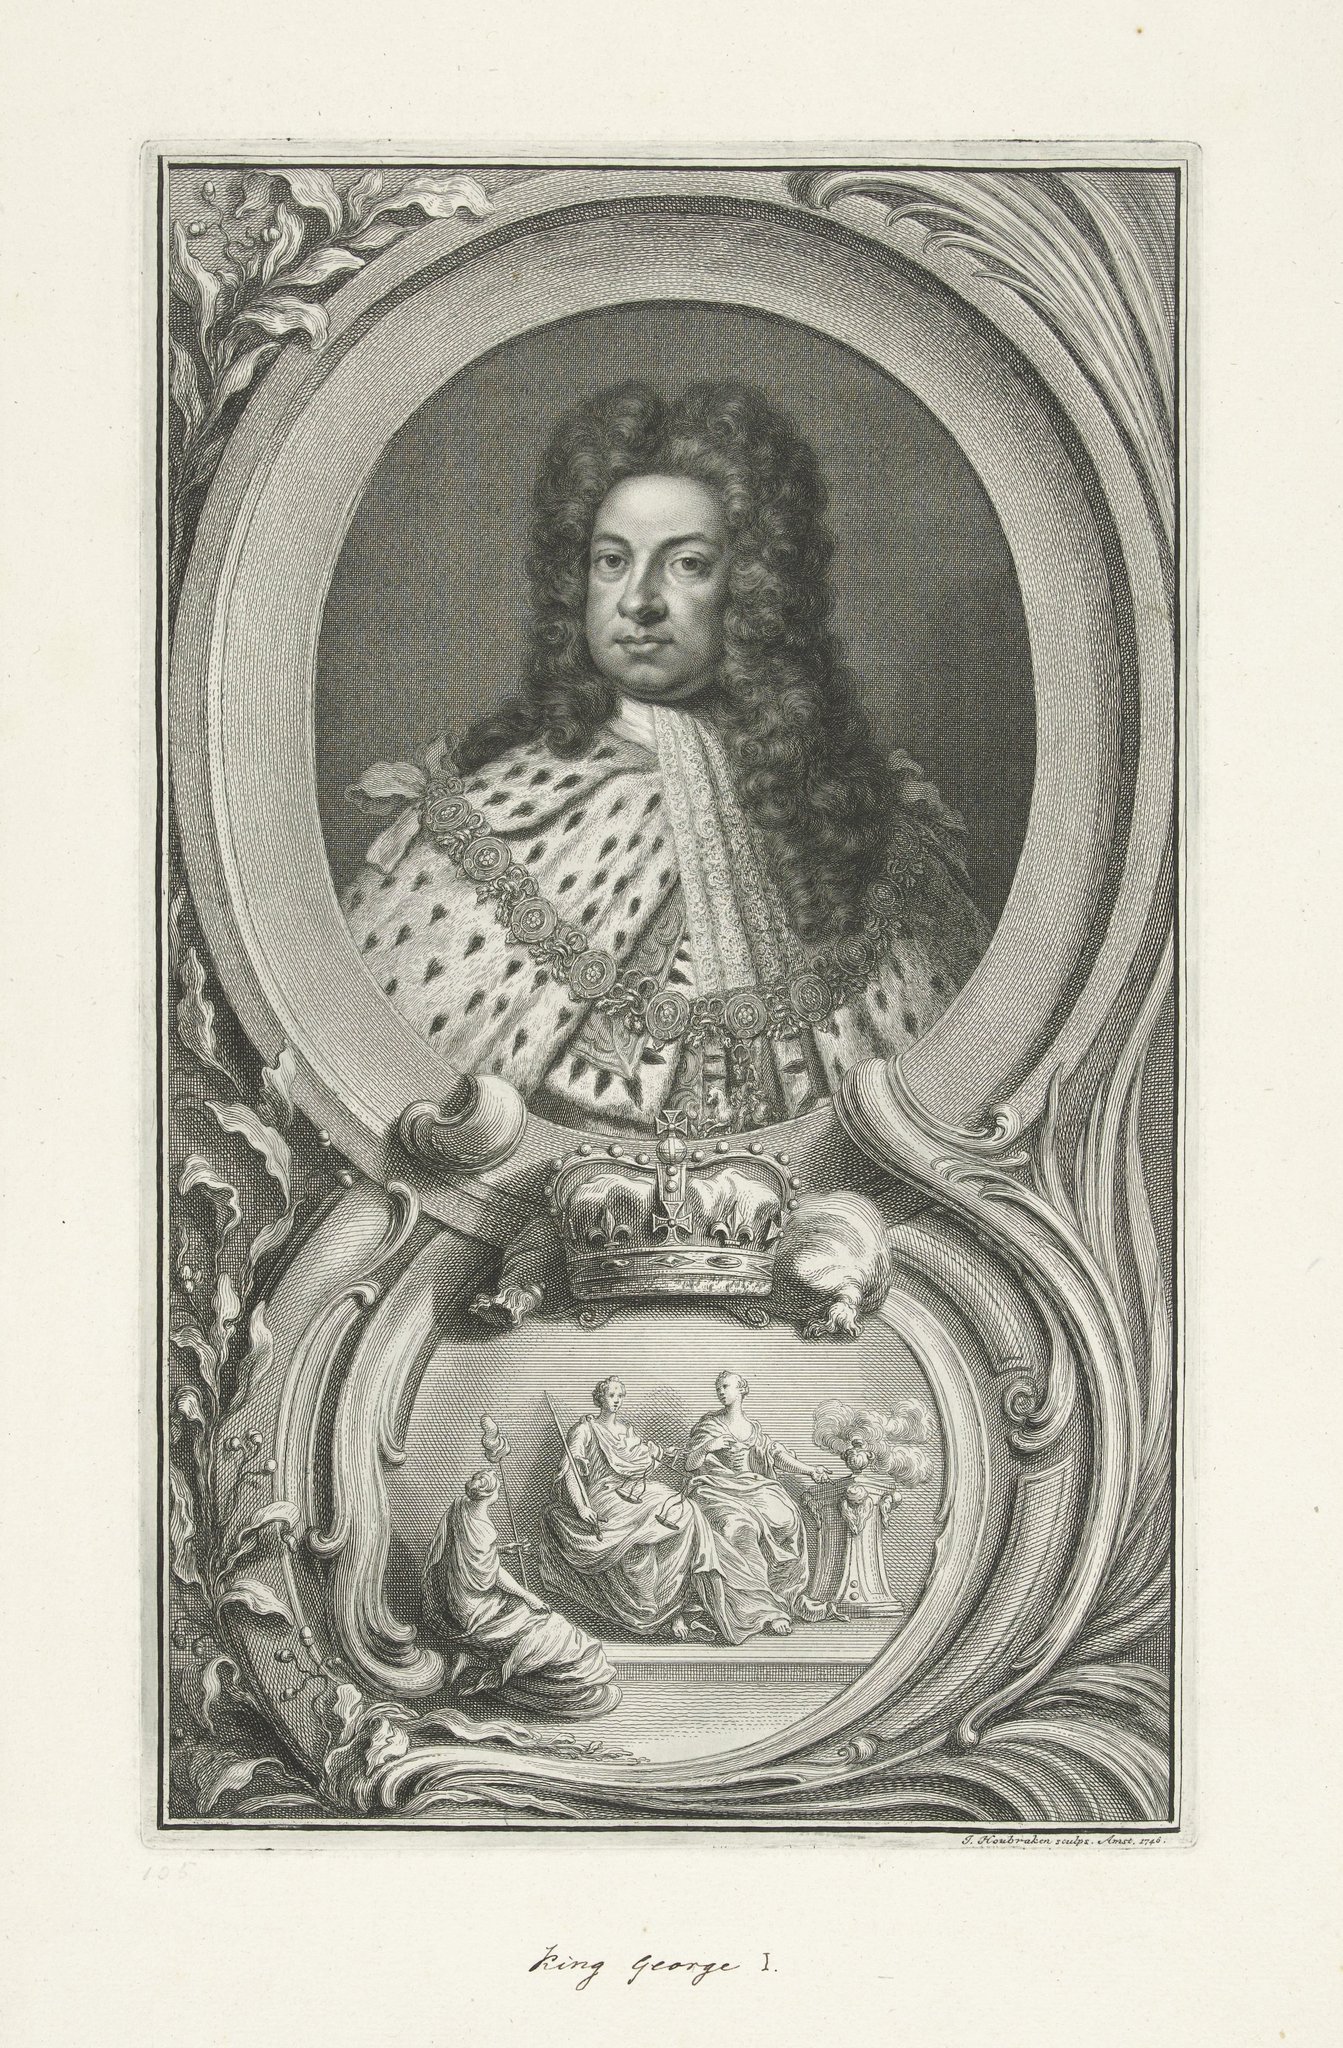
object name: print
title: Portret van George I, koning van Groot-Brittannië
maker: jacob houbraken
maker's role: draughtsman, print maker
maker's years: 1698-1780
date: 1746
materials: paper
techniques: engraving, etching, pen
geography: amsterdam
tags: george i (koning van groot-brittannië en ierland)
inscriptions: name: ‘king George I’, collector's mark: Lugt 240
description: Prent ook gebruikt in: Nicholas Tindal. The History of England, by Mr. Rapin de Thoyras. Continued from the Revolution to the Accession of King George II (...). 13 dln. Londen: John en Paul Knapton, 1744-1747.